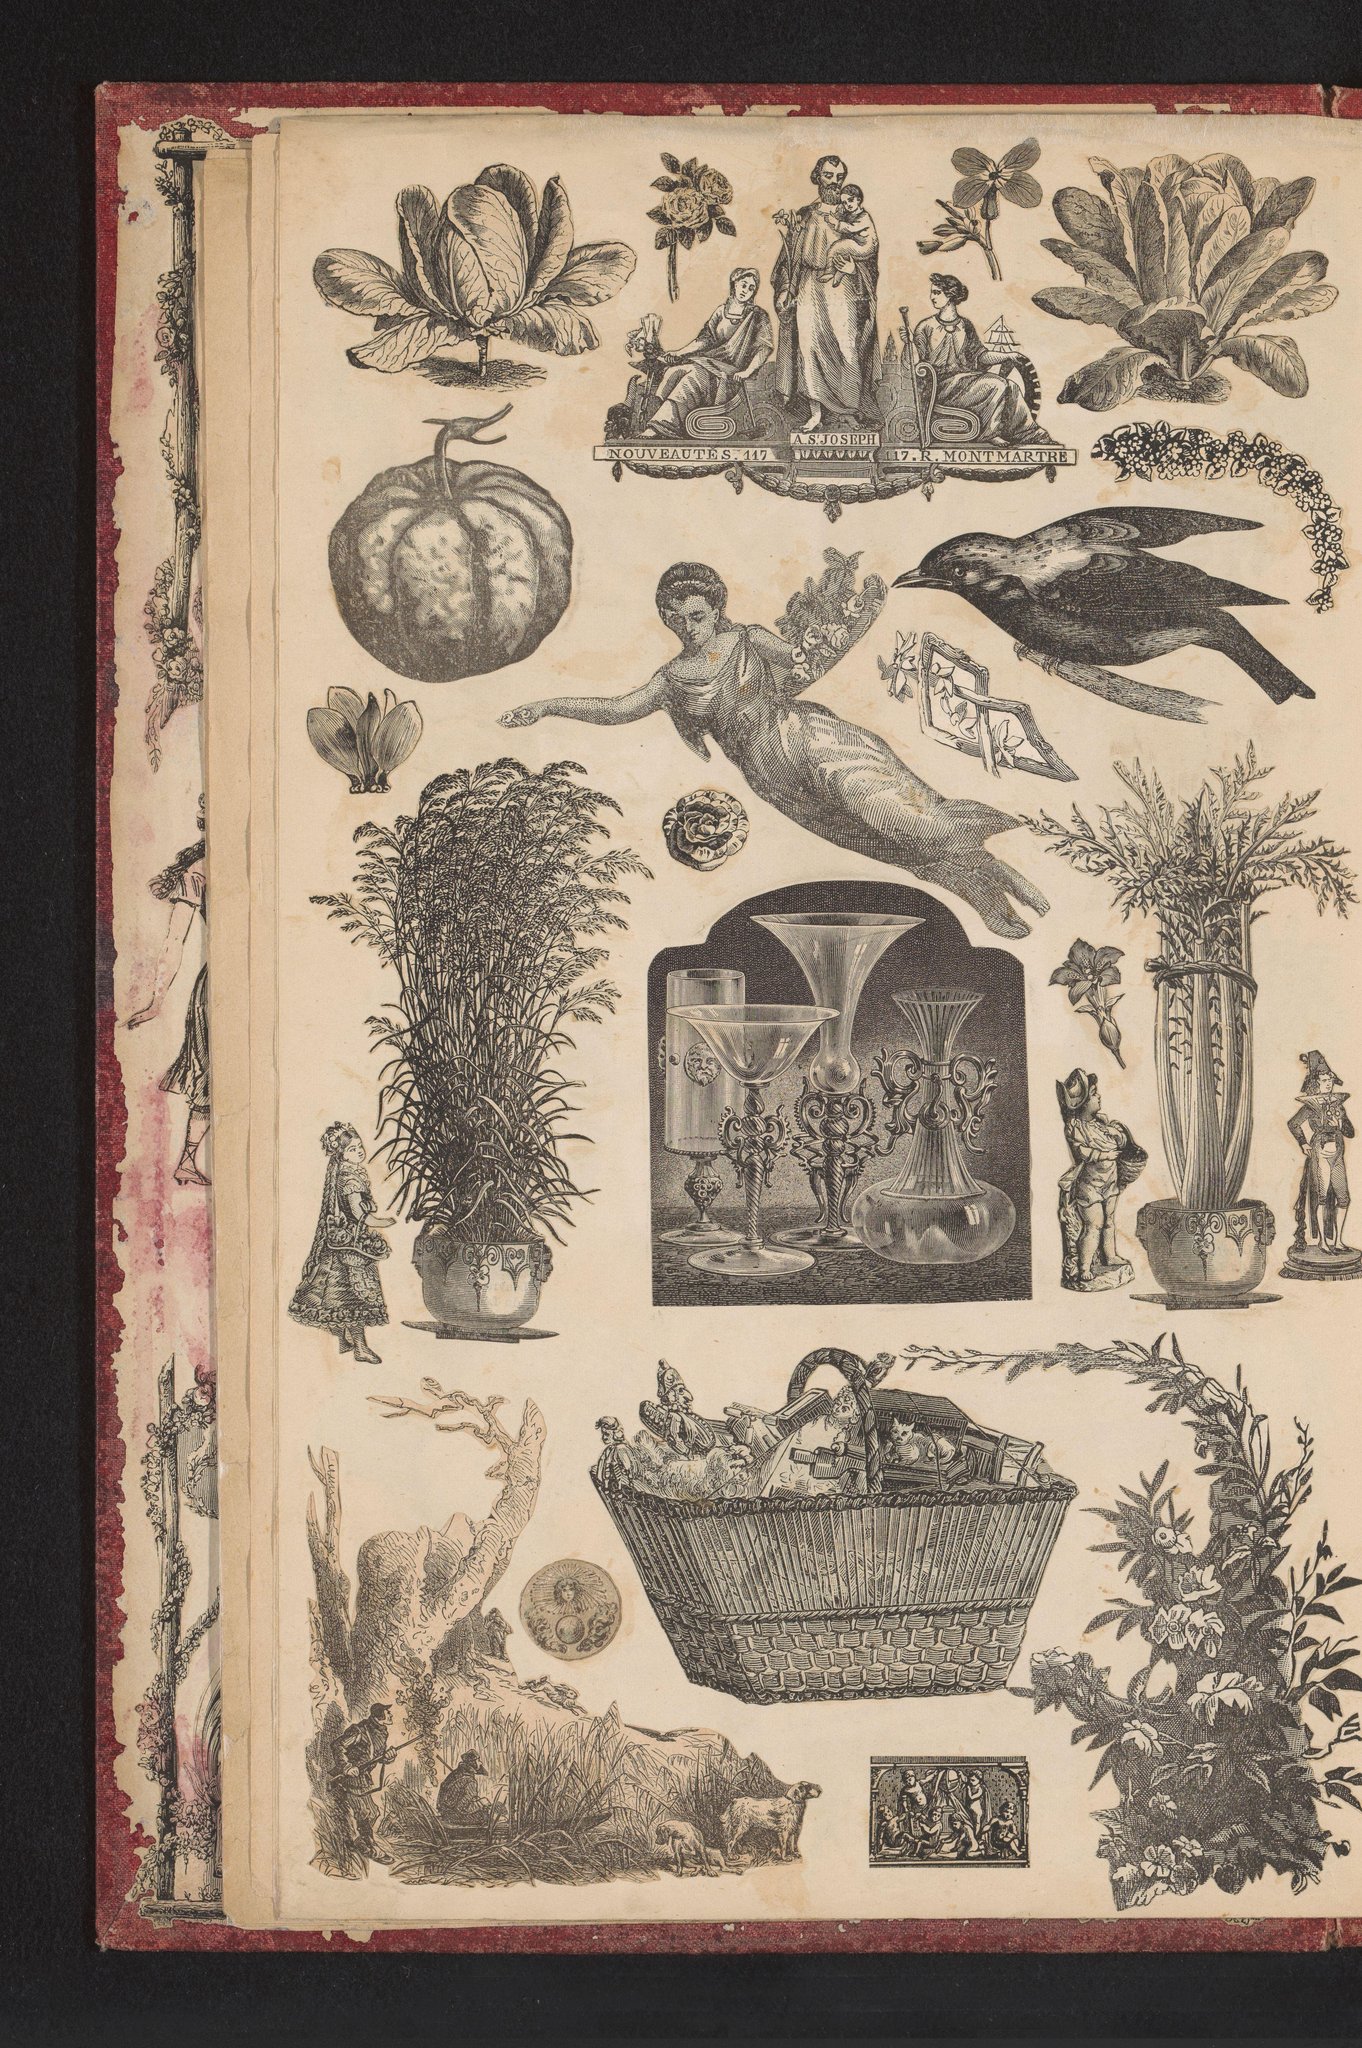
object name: collage visual work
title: Collage van uitgeknipte prenten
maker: Anonymous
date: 1870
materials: paper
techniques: engraving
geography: paris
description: Collage van uitgeknipte prenten. Onderdeel van een album met 32 bladen, aan beide zijden beplakt met uitgeknipte prenten, vermoedelijk afkomstig uit 19e-eeuwse tijdschiften.